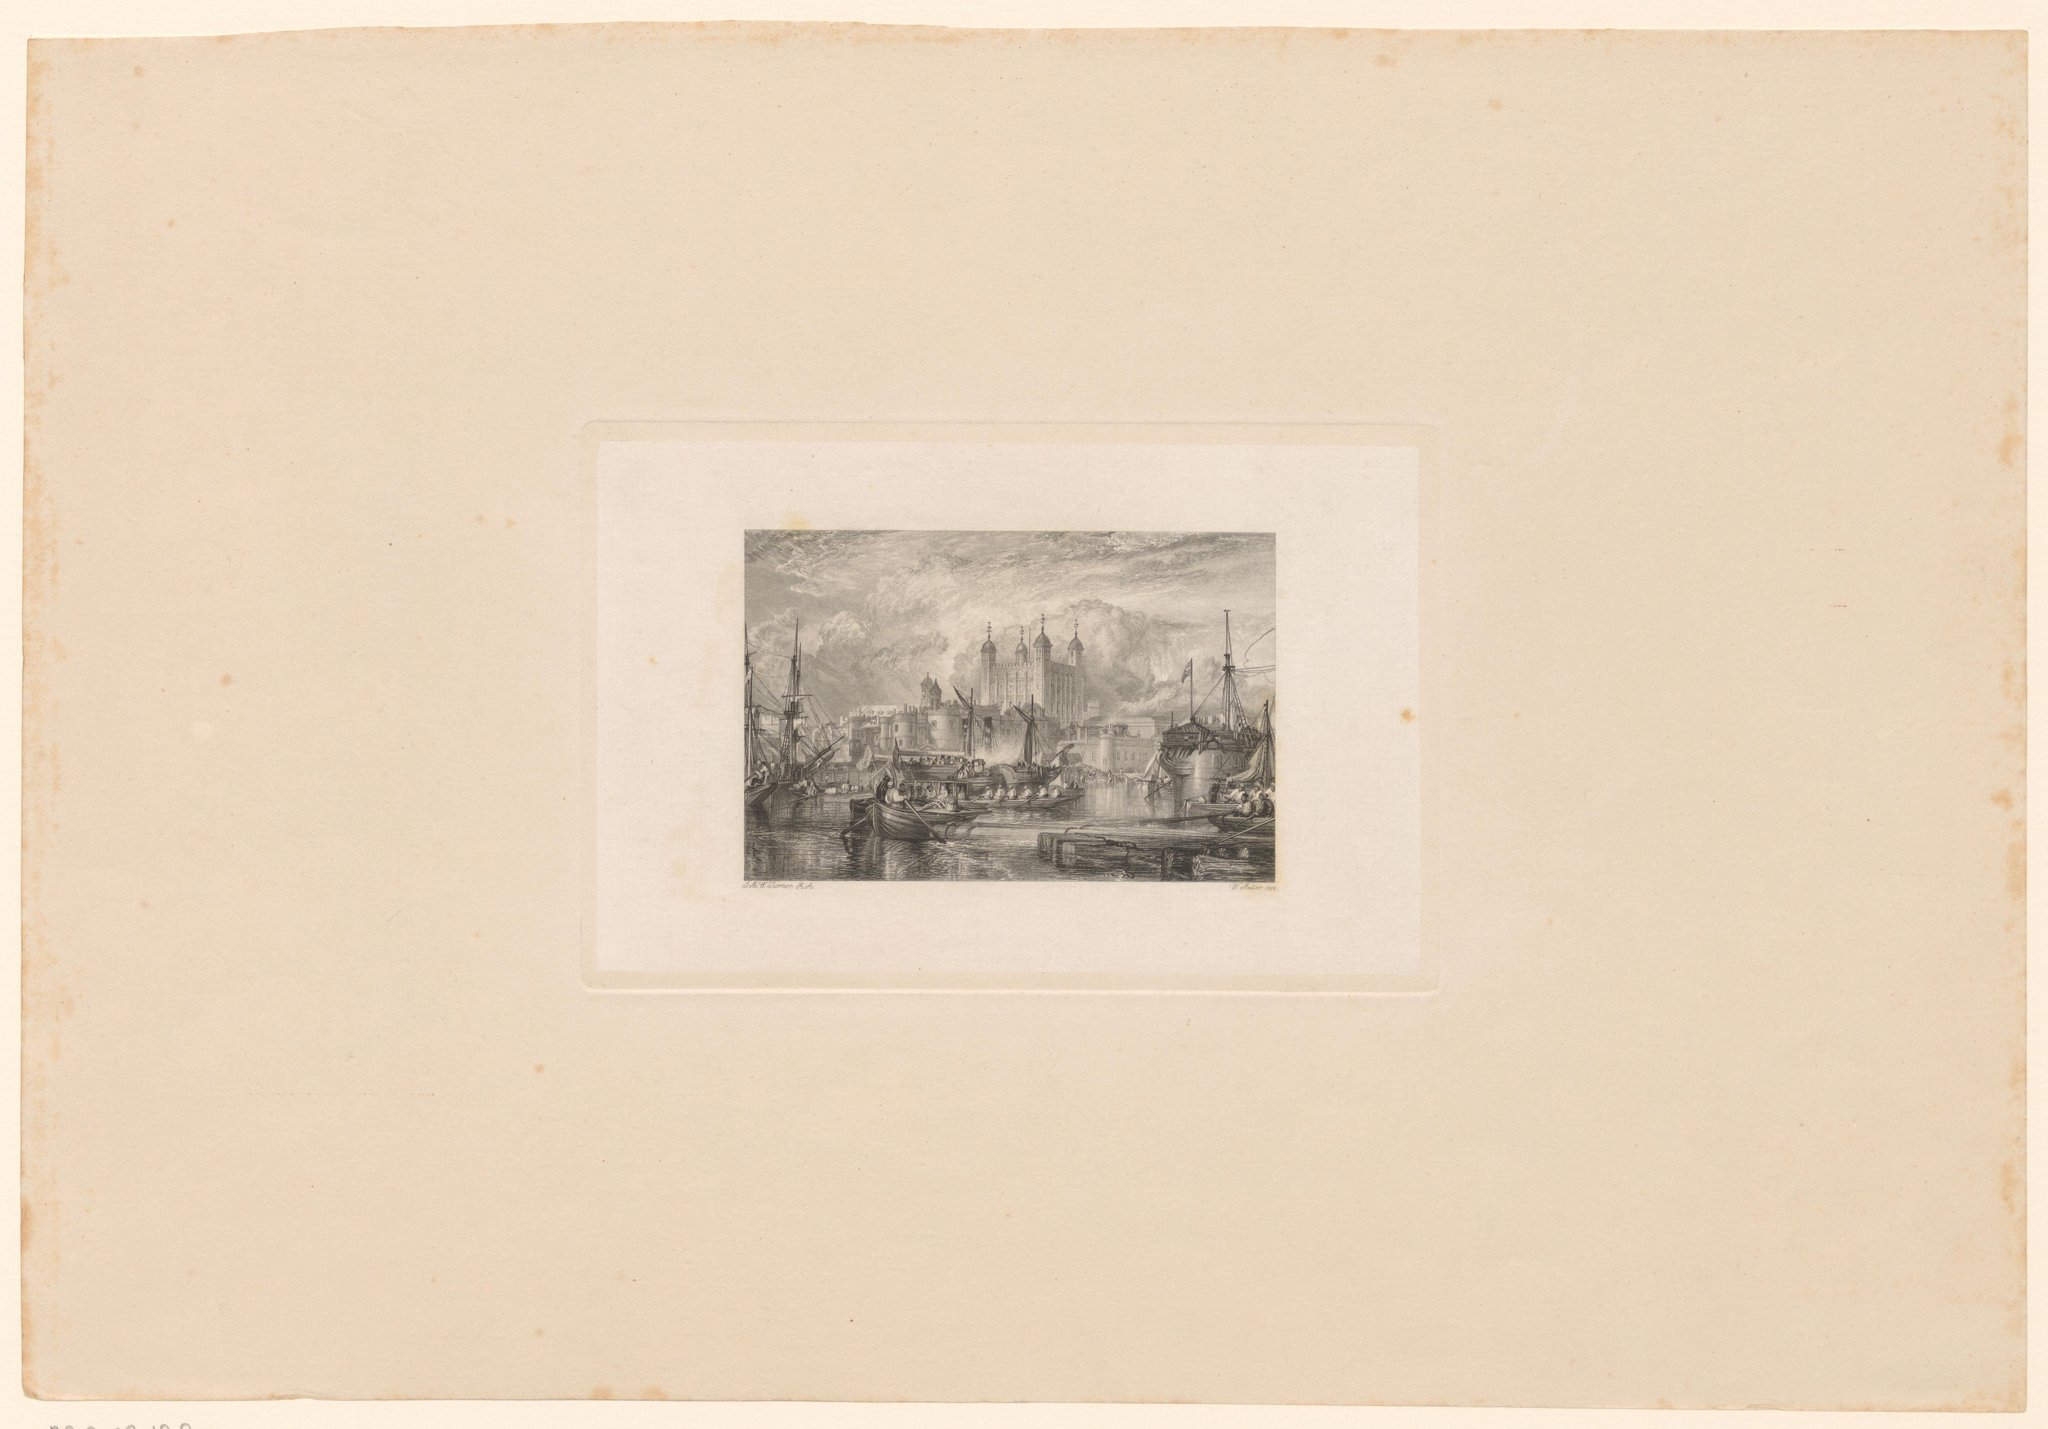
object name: print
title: Gezicht op de Tower of London vanaf de Theems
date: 1831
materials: paper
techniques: etching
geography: edinburgh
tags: sailing-ship, sailing-boat, river, rowing-boat, canoe, etc., thames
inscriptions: collector's mark: Lugt 2228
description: Latere staat gebruikt in: Watts, Alaric. The Literary Souvenir. Londen: Longman, Rees, Orme Brown & Green, 1832.